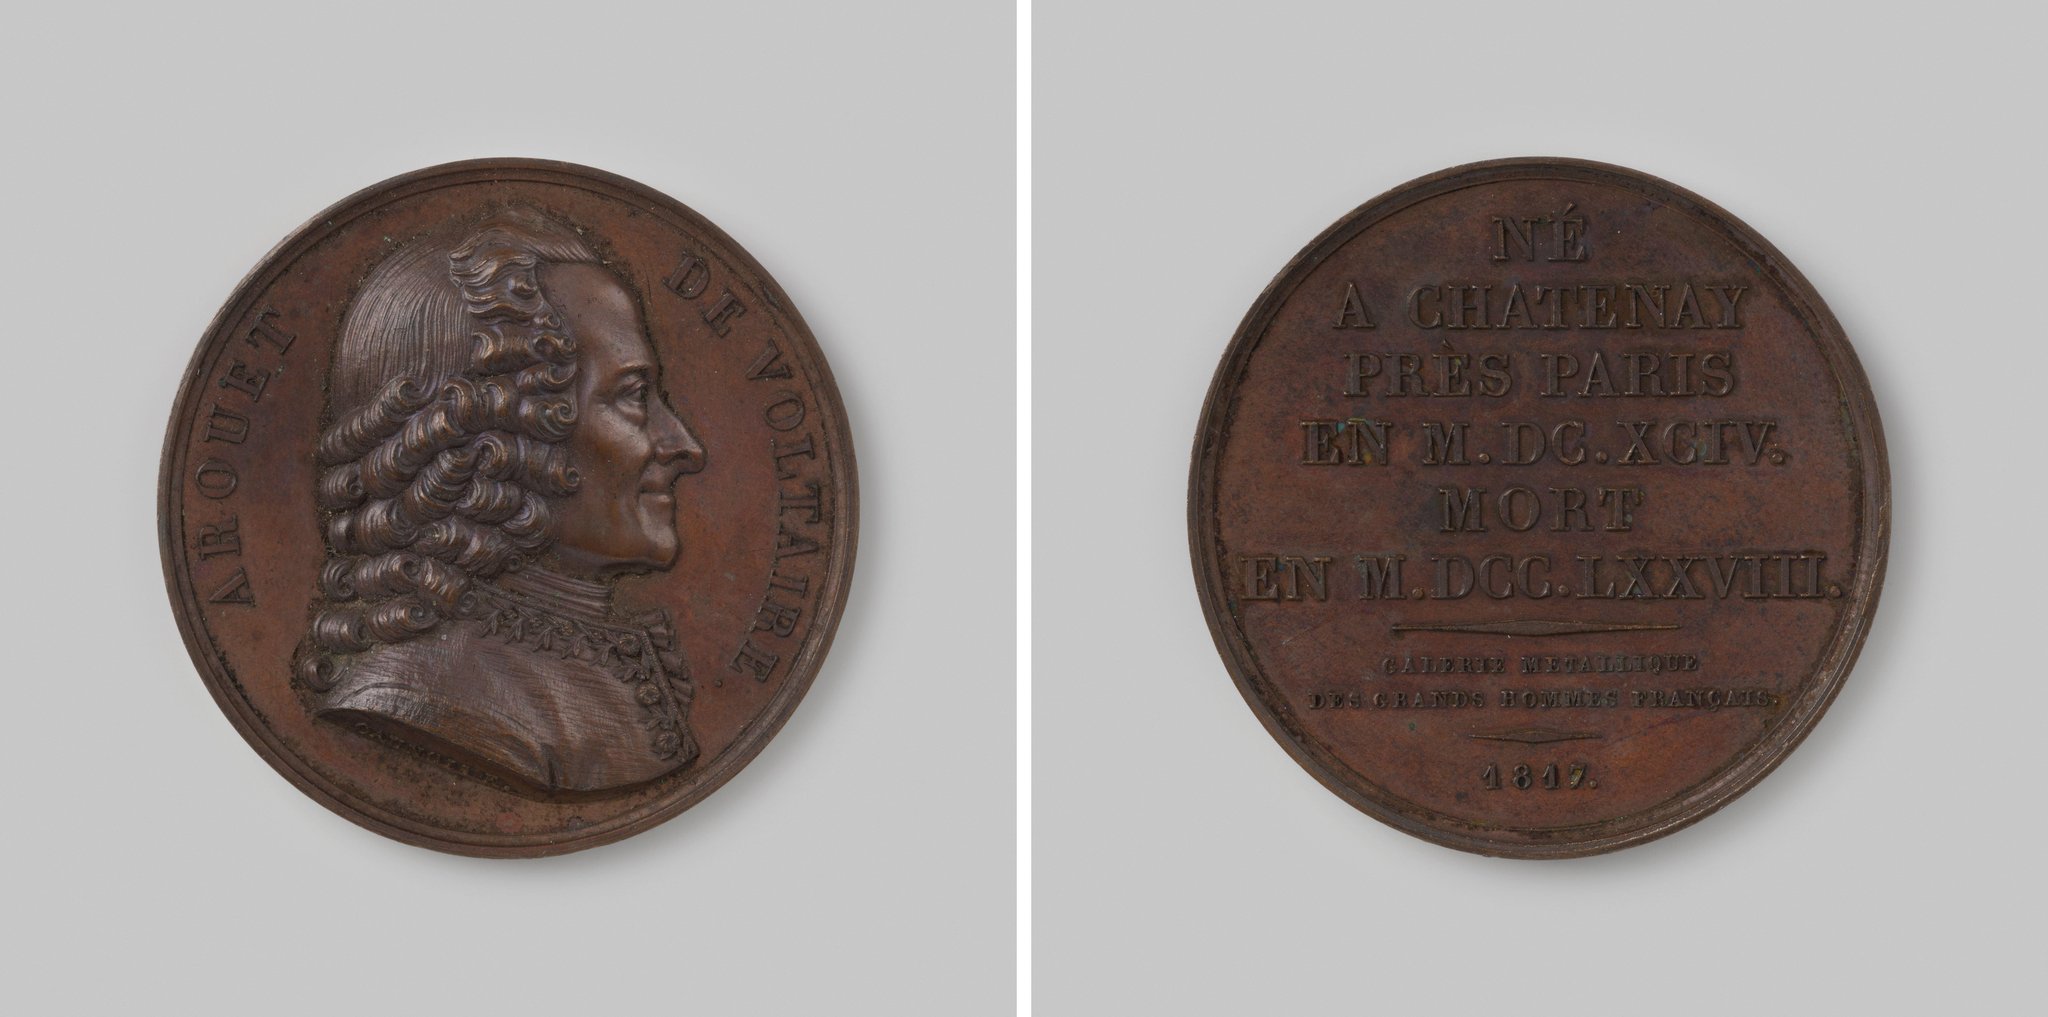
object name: history medal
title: Grands Hommes Français: Arouet de Voltaire (1817)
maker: françois augustin caunois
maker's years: 1787-1859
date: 1817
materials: bronze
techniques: striking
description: Bronzen penning, op de voorzijde het borstbeeld van Voltaire naar rechts met omschrift, op de keerzijde negen regels tekst.